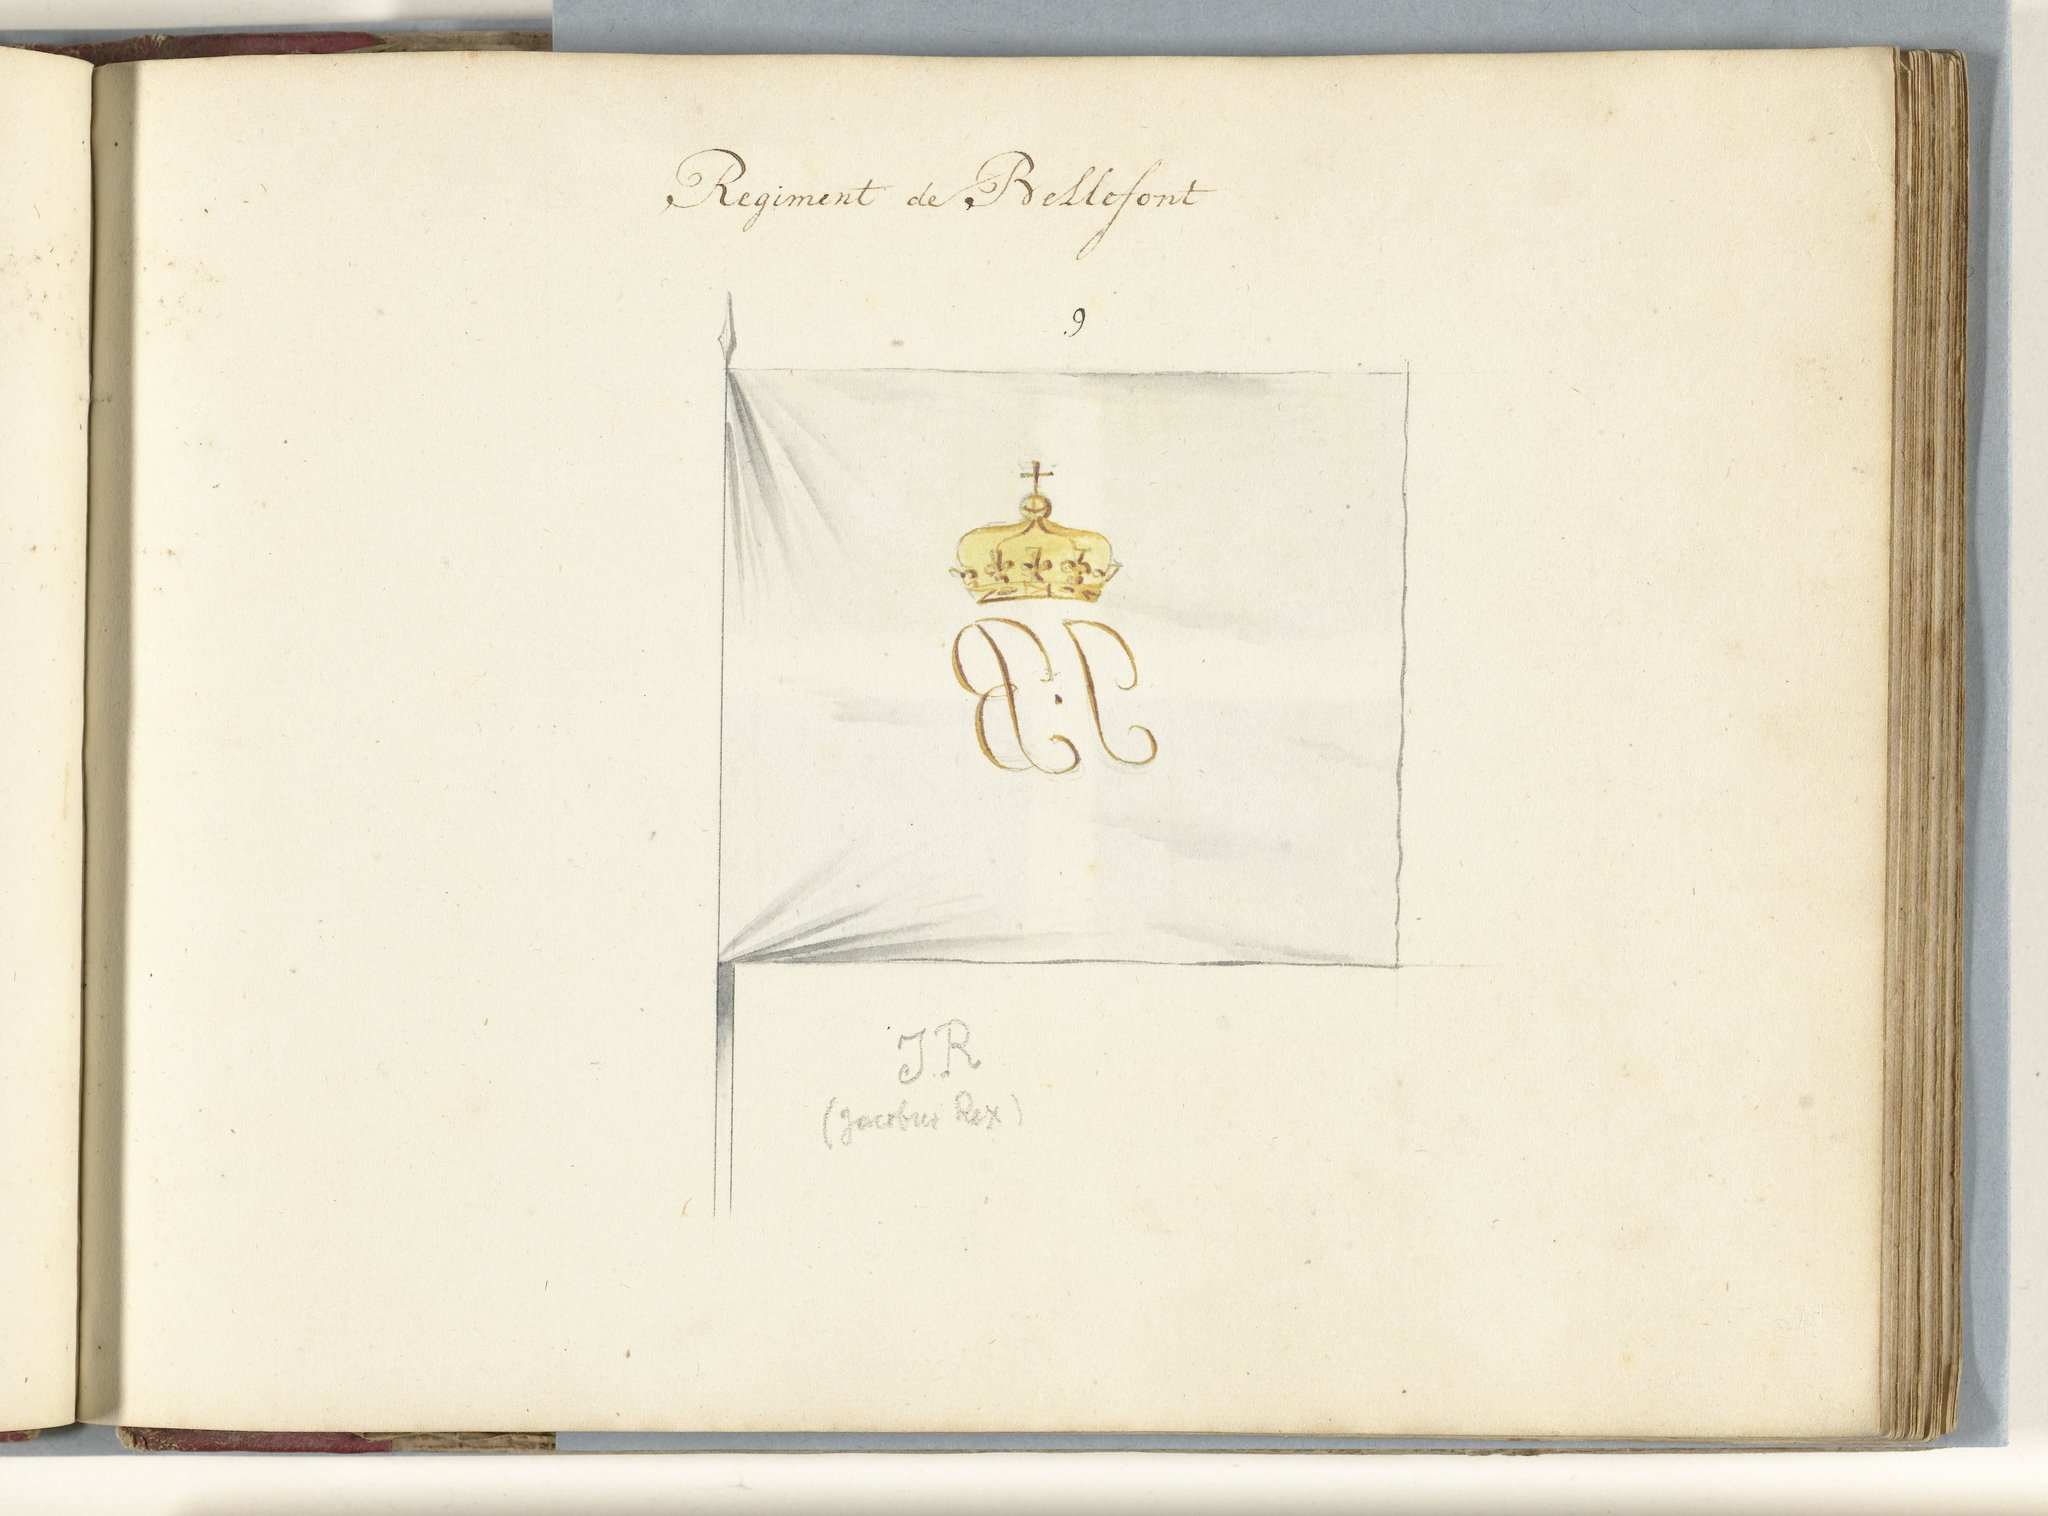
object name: drawing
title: Frans vaandel veroverd in de slag bij Malplaquet, 1709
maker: Anonymous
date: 1713-1720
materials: paper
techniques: drawing, writing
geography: northern netherlands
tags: london, (military) flags and standards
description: Frans vaandel veroverd bij de slag bij Malplaquet in 1709. Op het vaandel de letters JR van Jacobus Rex (James Francis Edward Stuart). In het boek met tekeningen van Franse vaandels, standaarden en pauken, veroverd tijdens de Spaanse Successieoorlog (1701-1713).